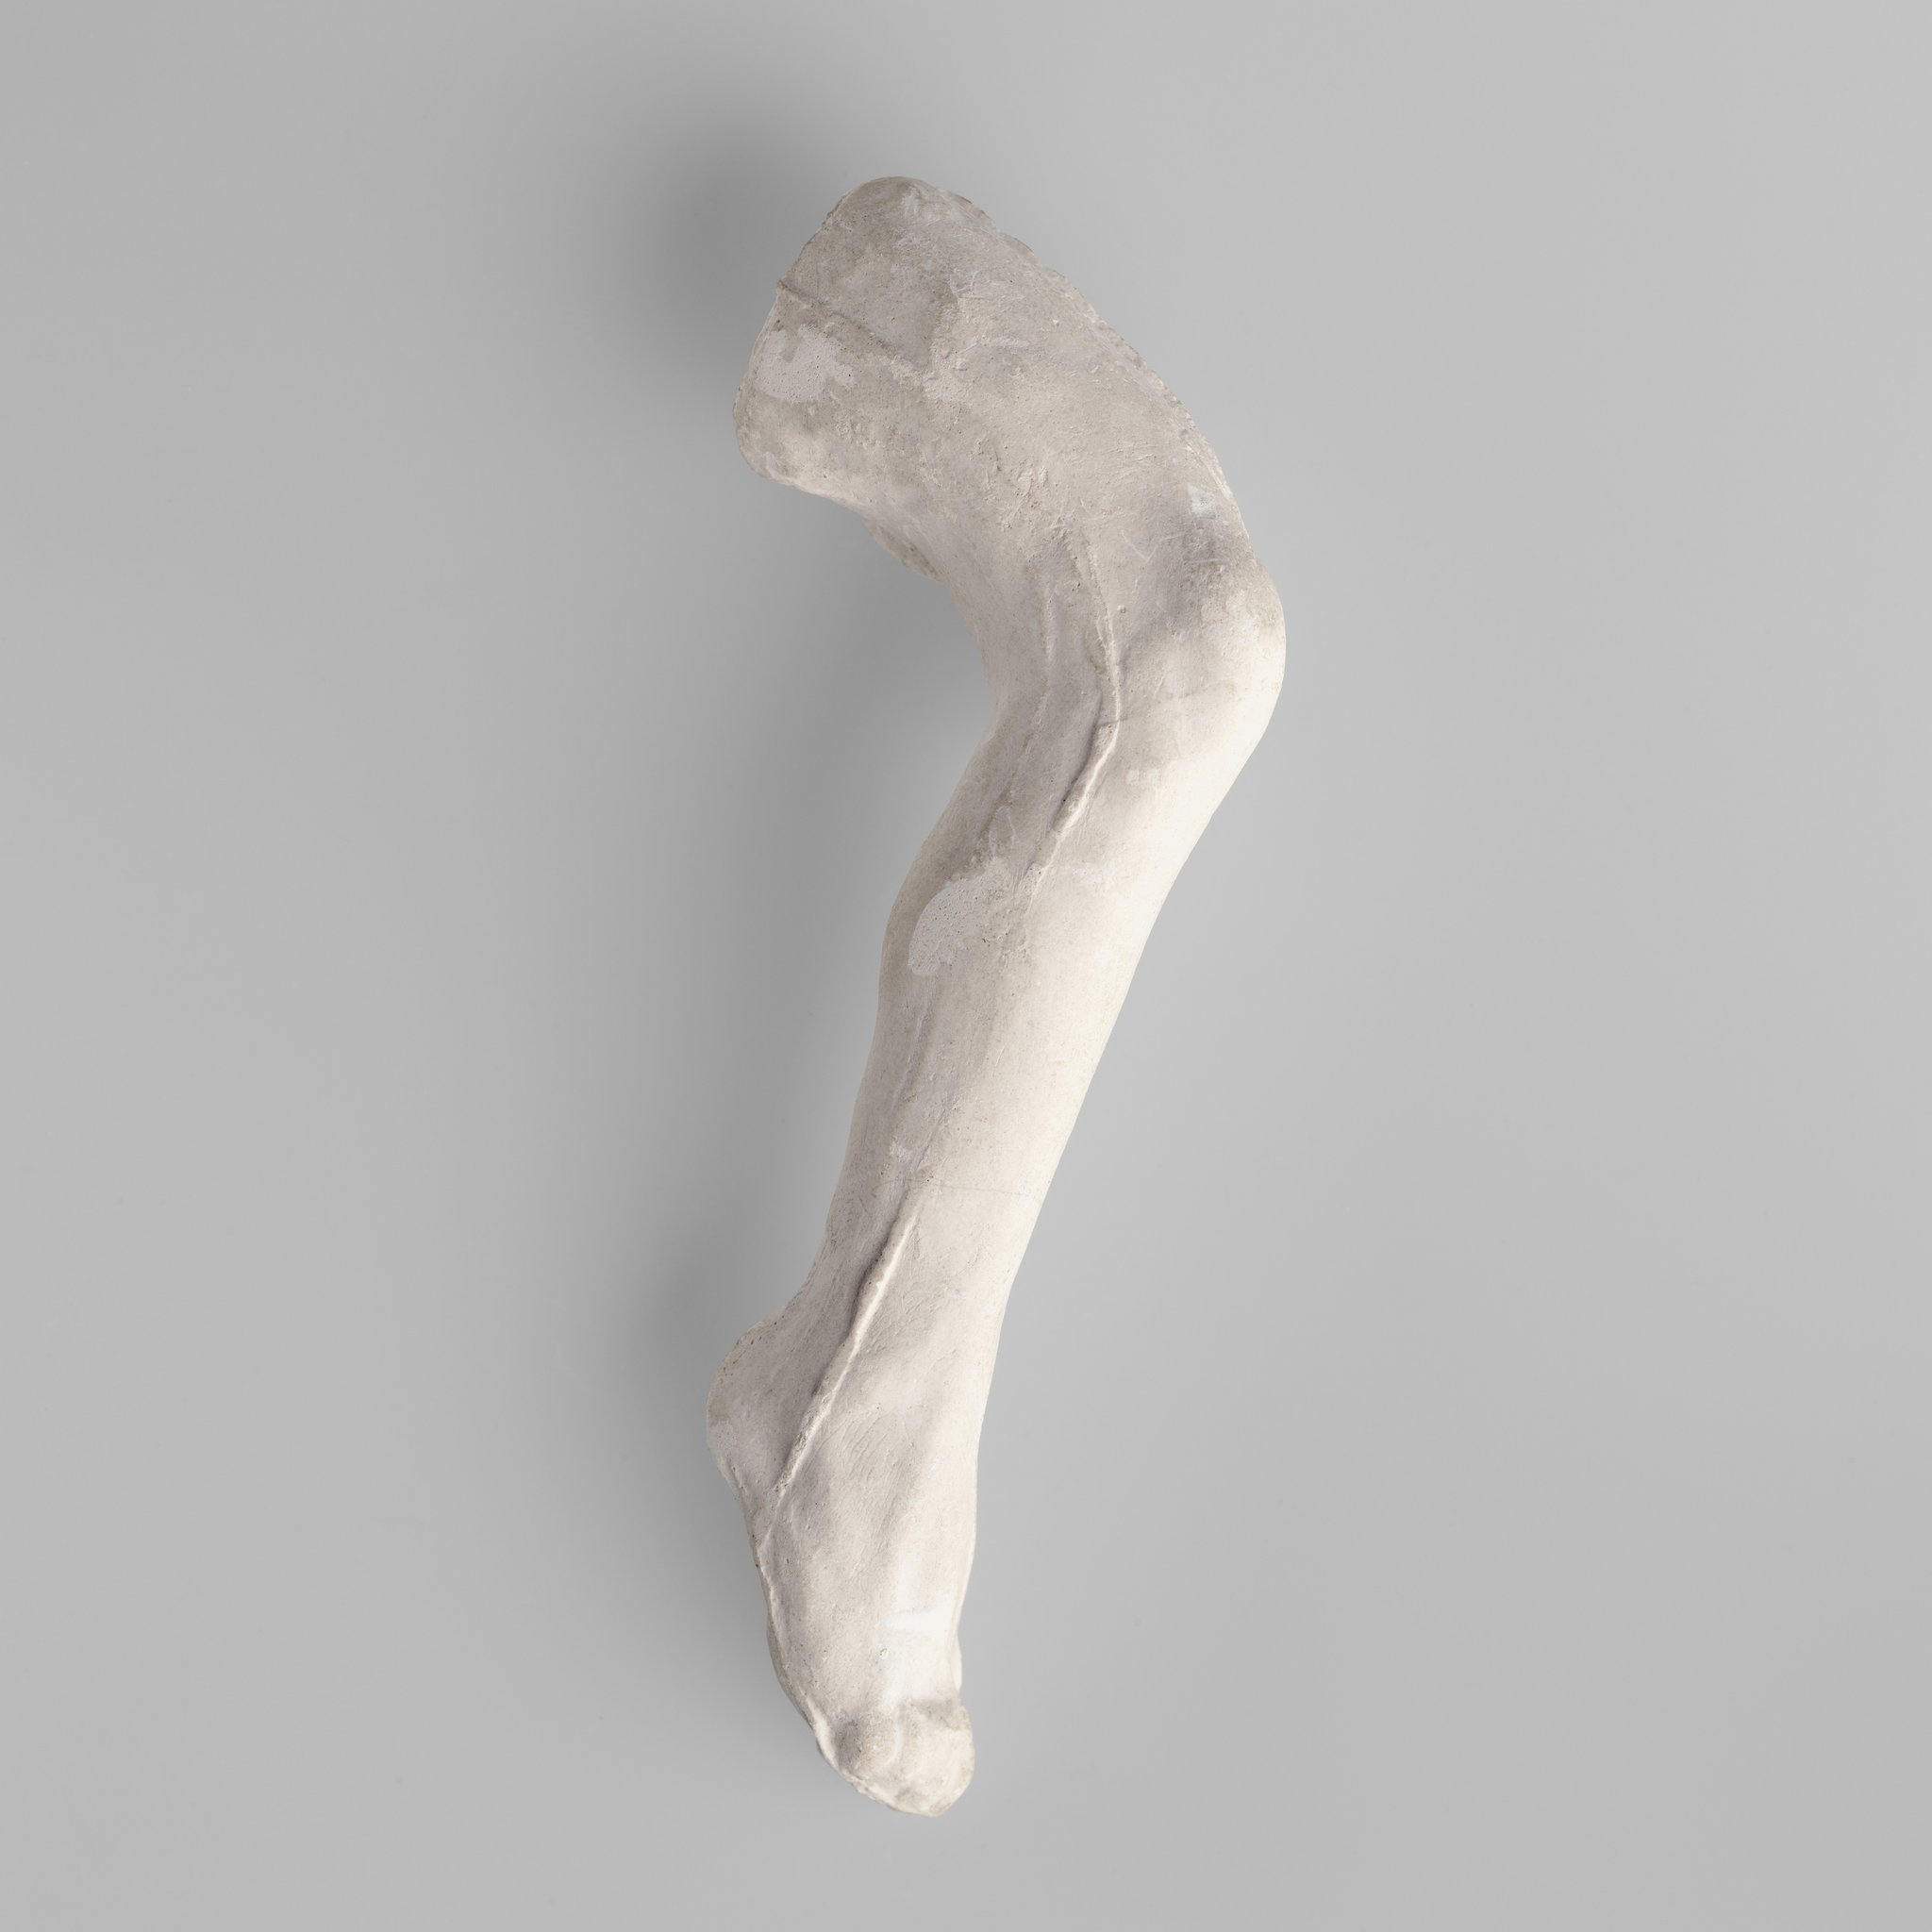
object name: cast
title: Study of a leg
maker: auguste rodin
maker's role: artist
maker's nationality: french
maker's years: 1840-1917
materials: plaster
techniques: casting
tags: legs